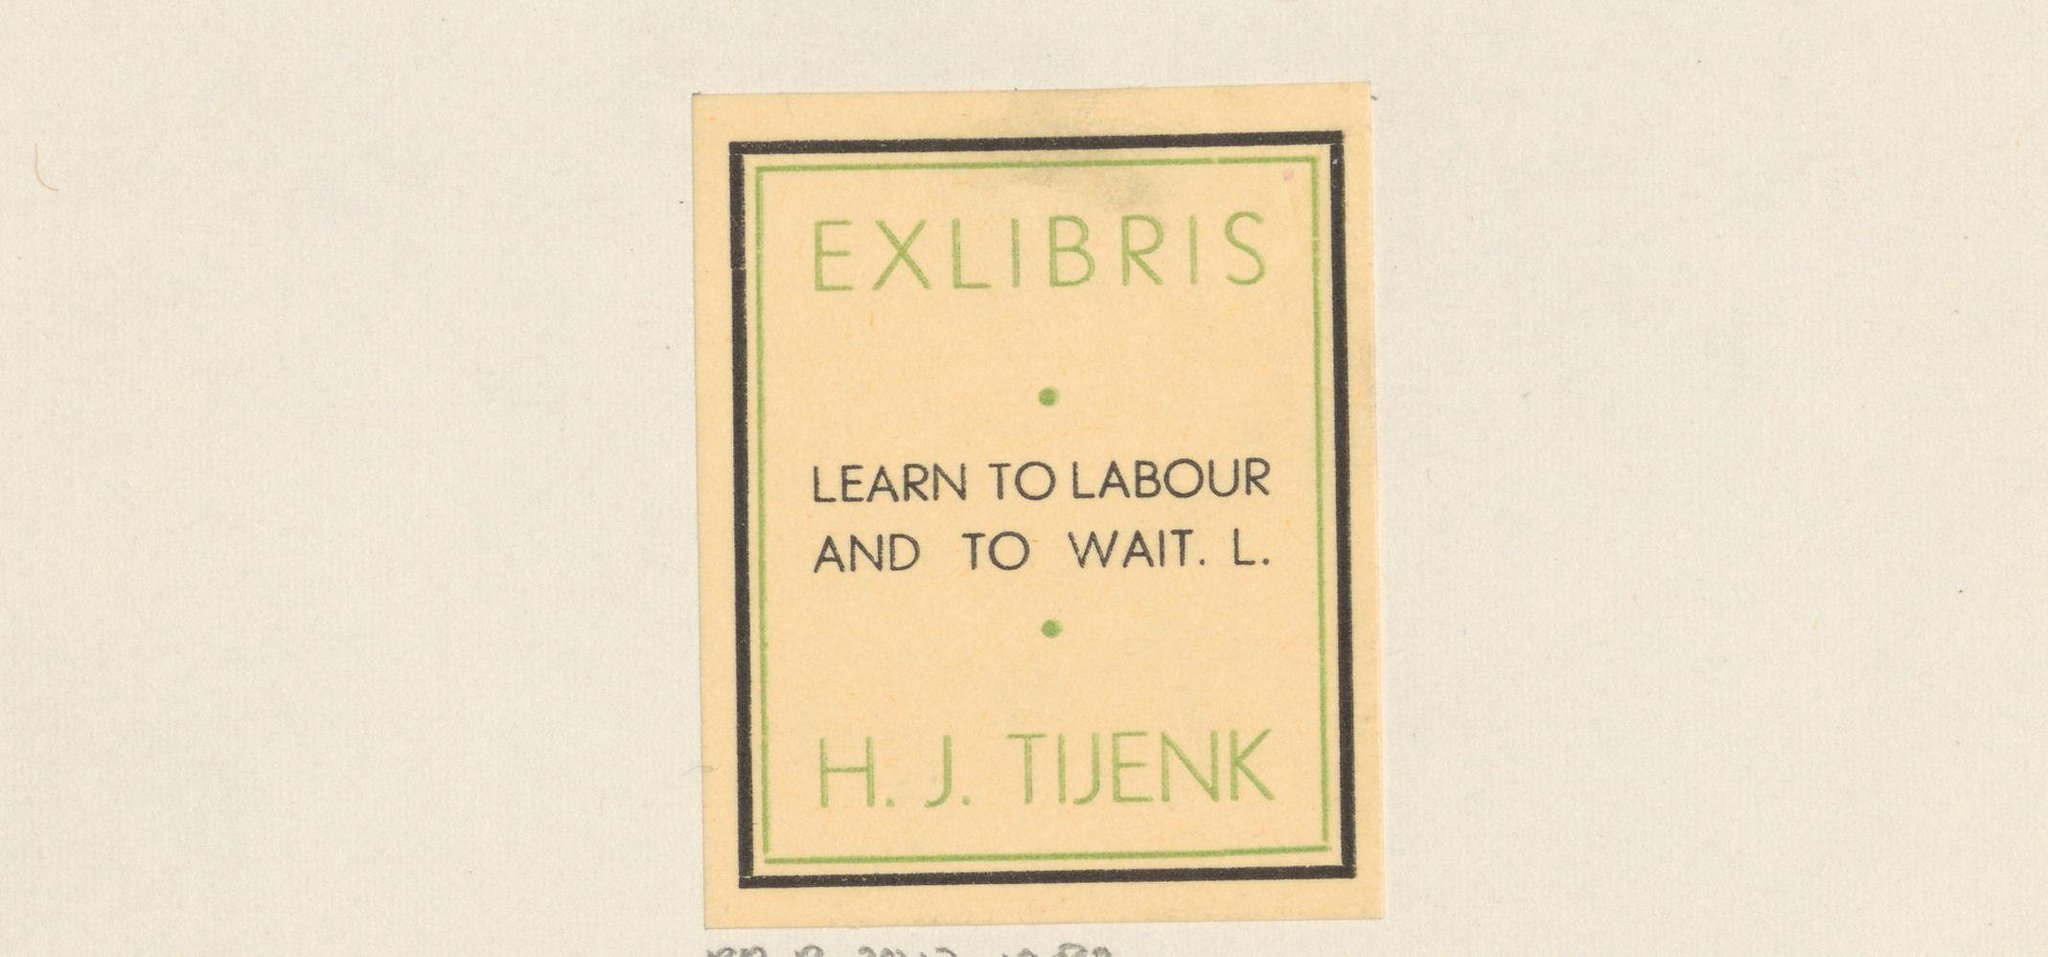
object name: bookplate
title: Ex libris van H.J. Tijenk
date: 1938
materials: paper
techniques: printing block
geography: netherlands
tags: h.j. tijenk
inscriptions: signature and date: ‘typ ipse 1938’